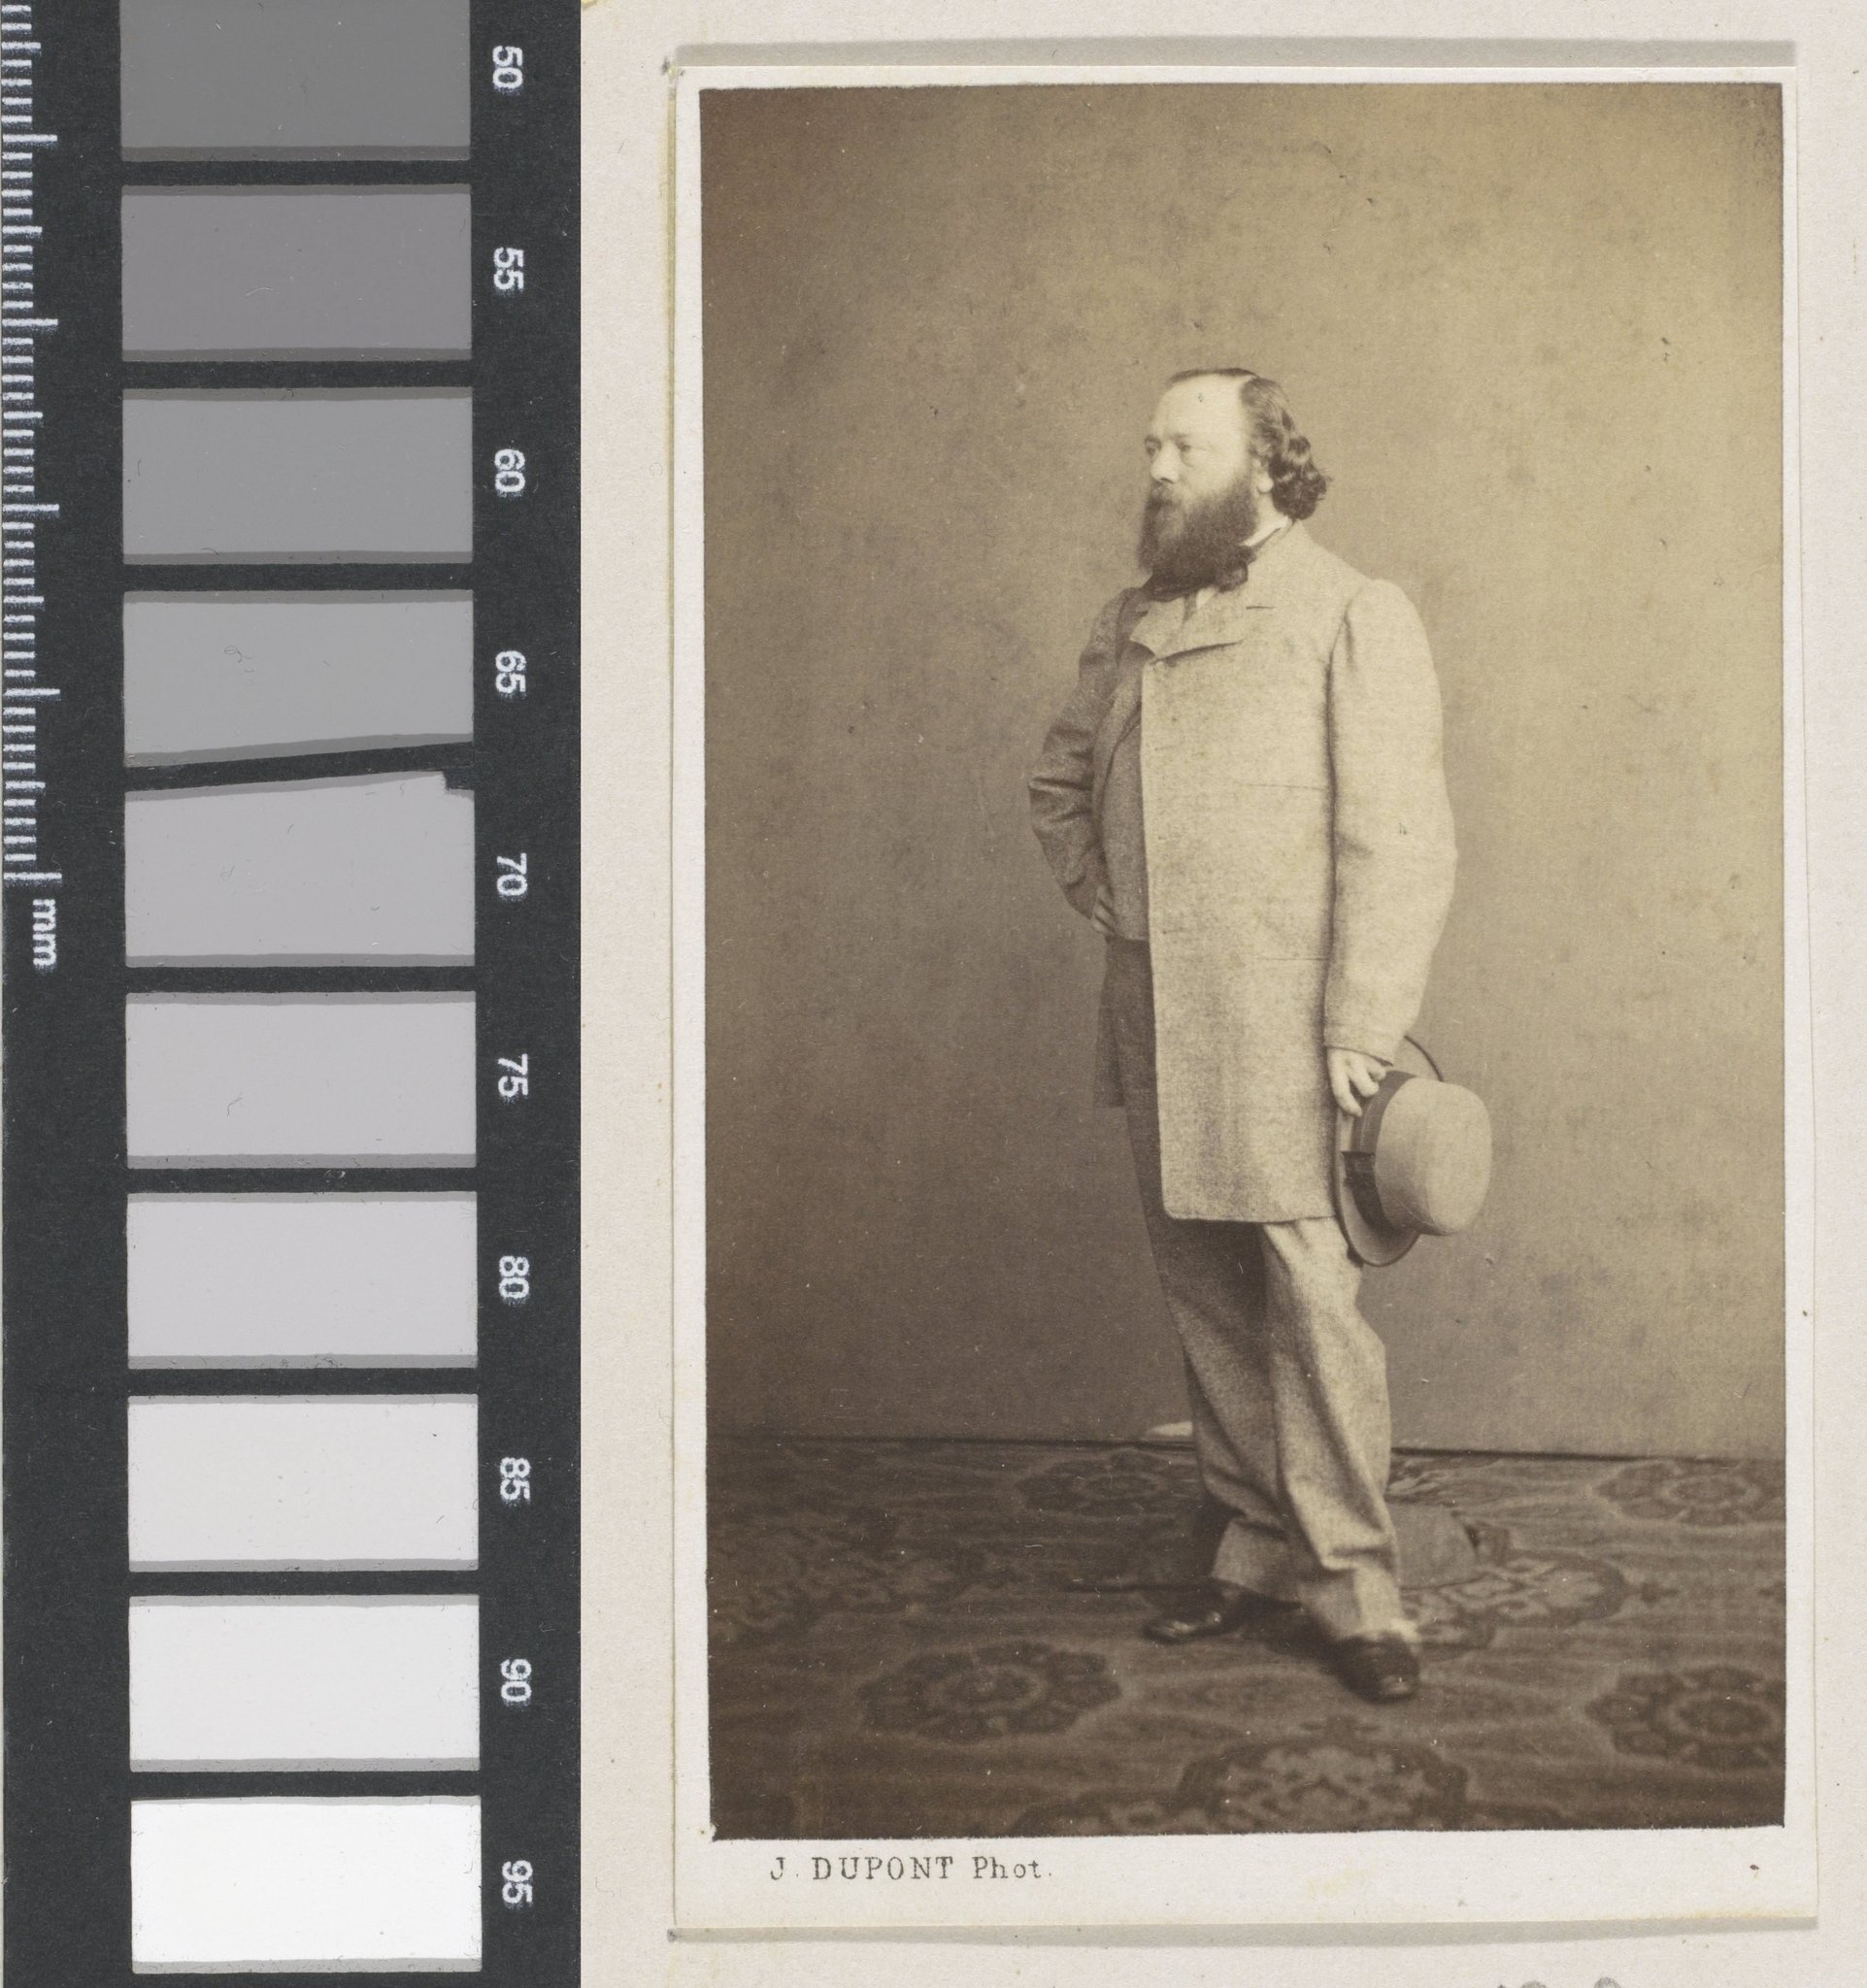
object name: photograph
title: Portret van de schilder Victor Lagye, ten voeten uit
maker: joseph dupont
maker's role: fotograaf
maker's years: 1818-1901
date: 1861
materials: cardboard, paper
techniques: albumen print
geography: antwerp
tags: ghent, antwerp, victor lagye, historical persons, portrait, self-portrait of painter, portrait, self-portrait of artist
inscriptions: inscription: ‘ETABLISSEMENT PHOTOGRAPHIQUE/ de/ J. DUPONT/ Place de Meir 32/ ANVERS/ Maison fondée en 1853’